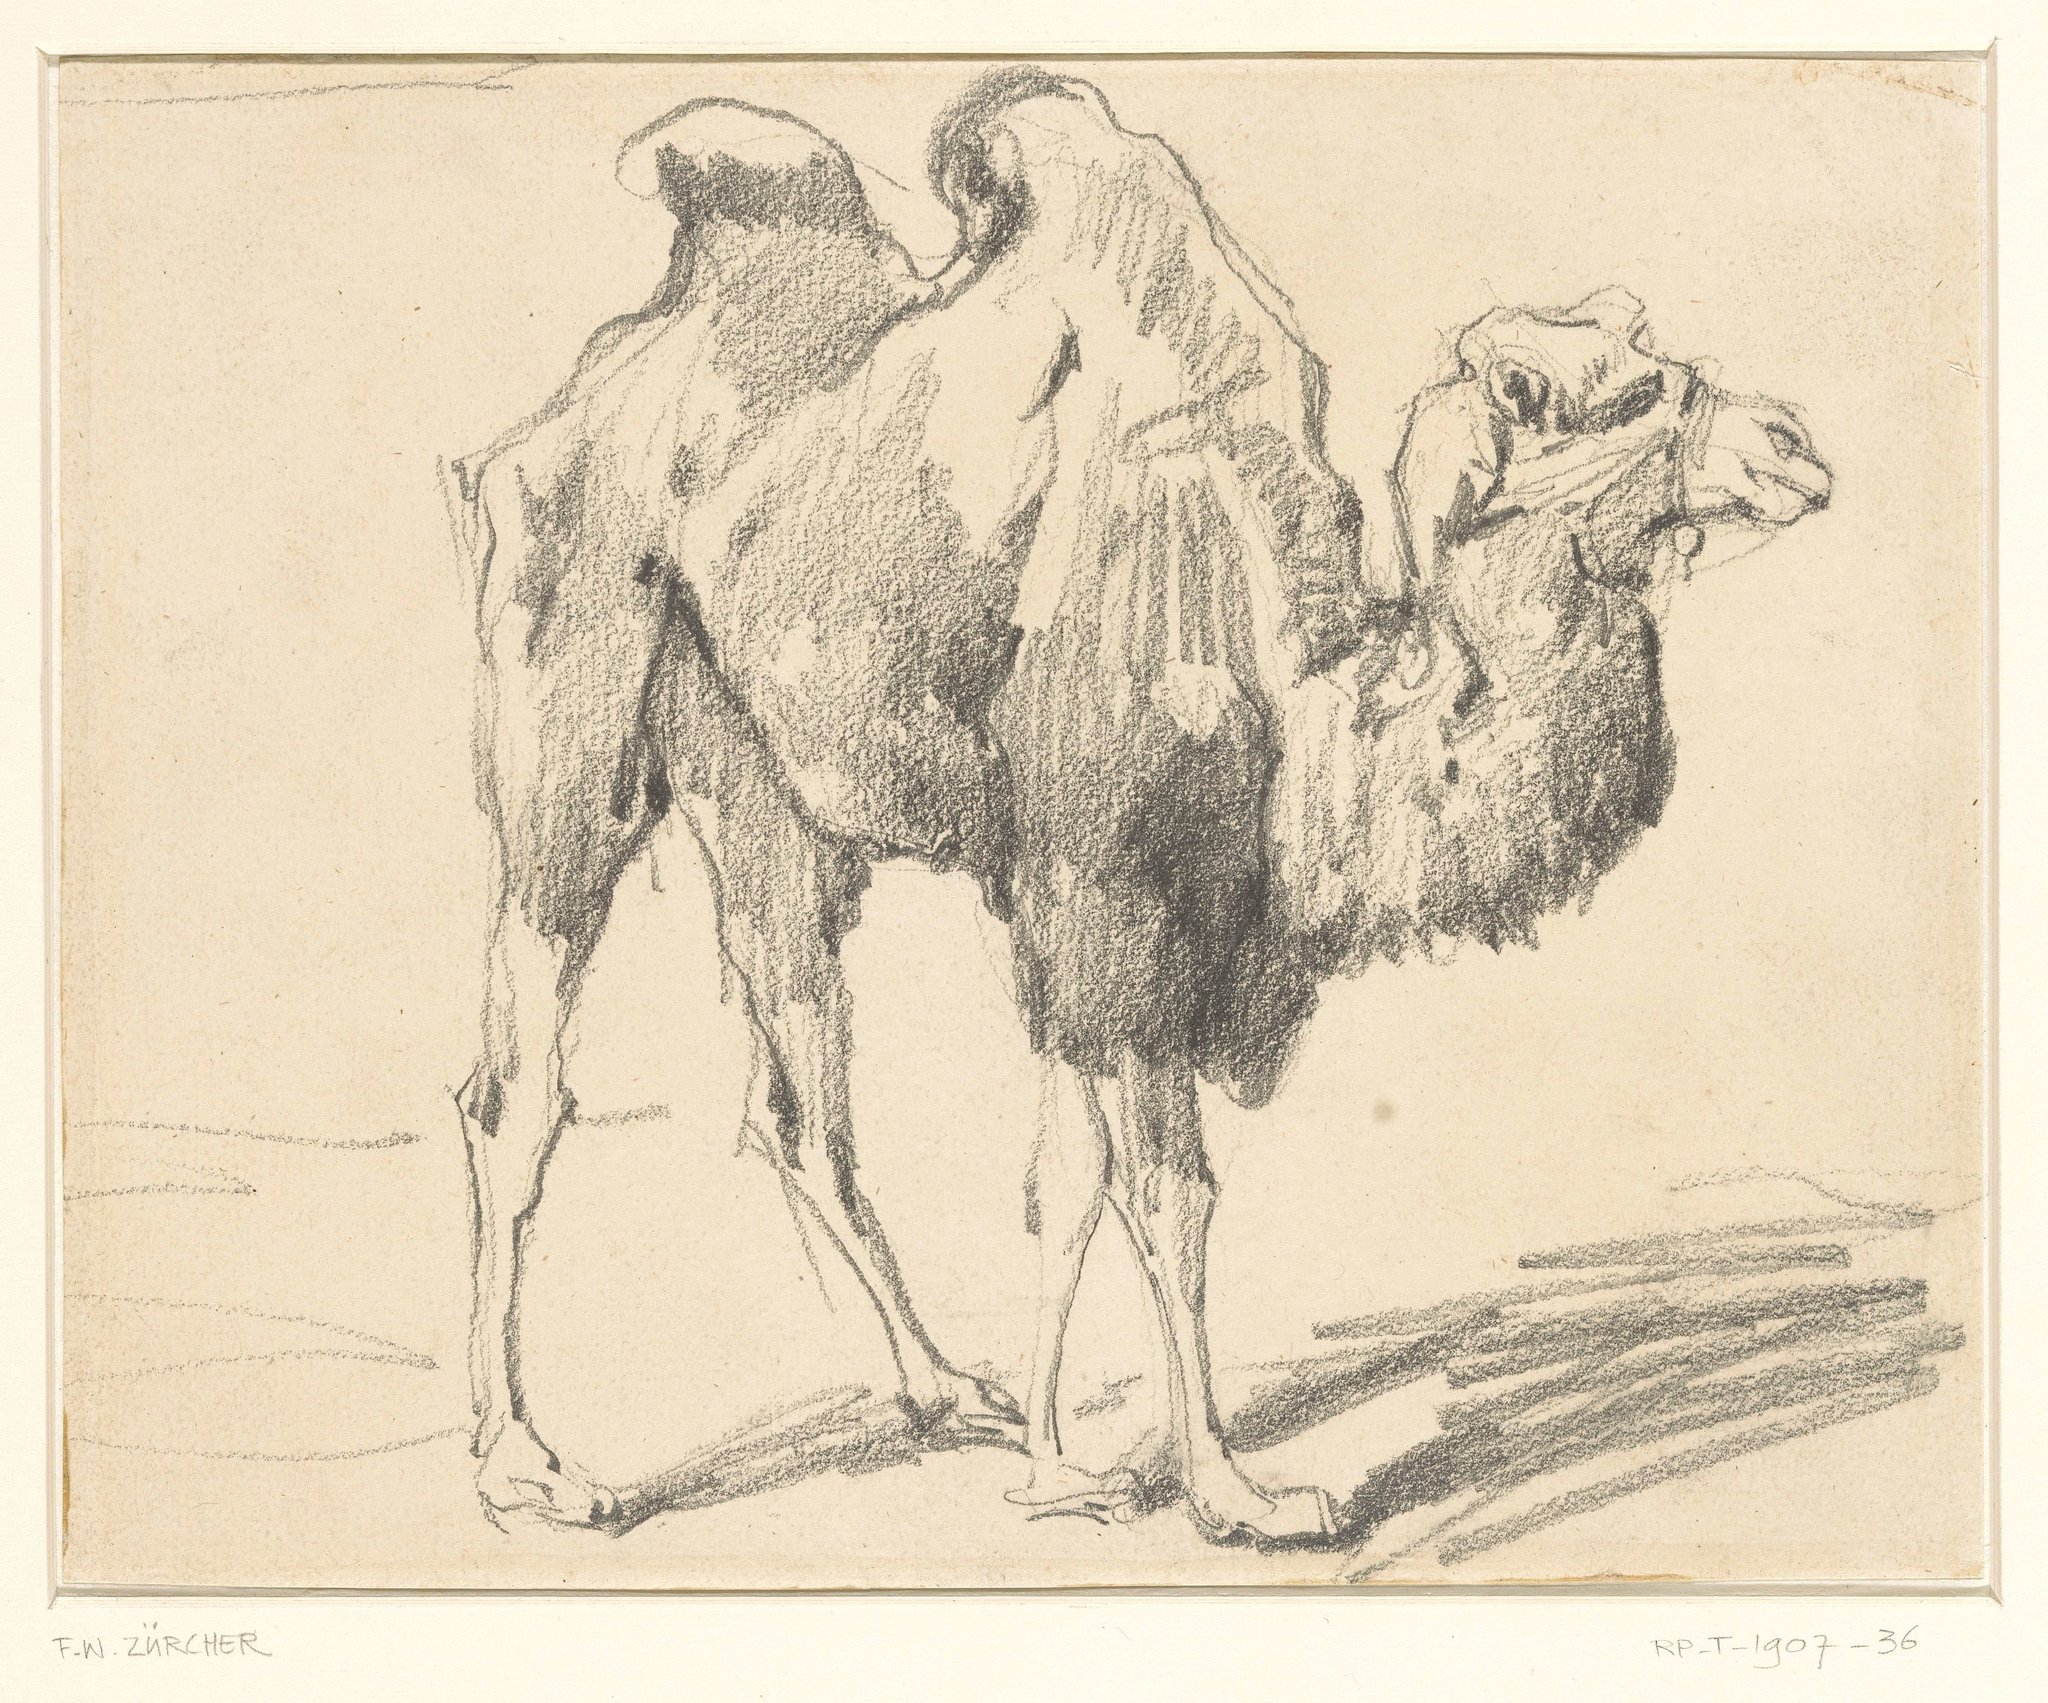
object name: drawing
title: Kameel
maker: frederik willem zürcher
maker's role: draughtsman, print maker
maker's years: 1835-1894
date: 1845-1894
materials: paper, pencil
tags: hoofed animals: camel